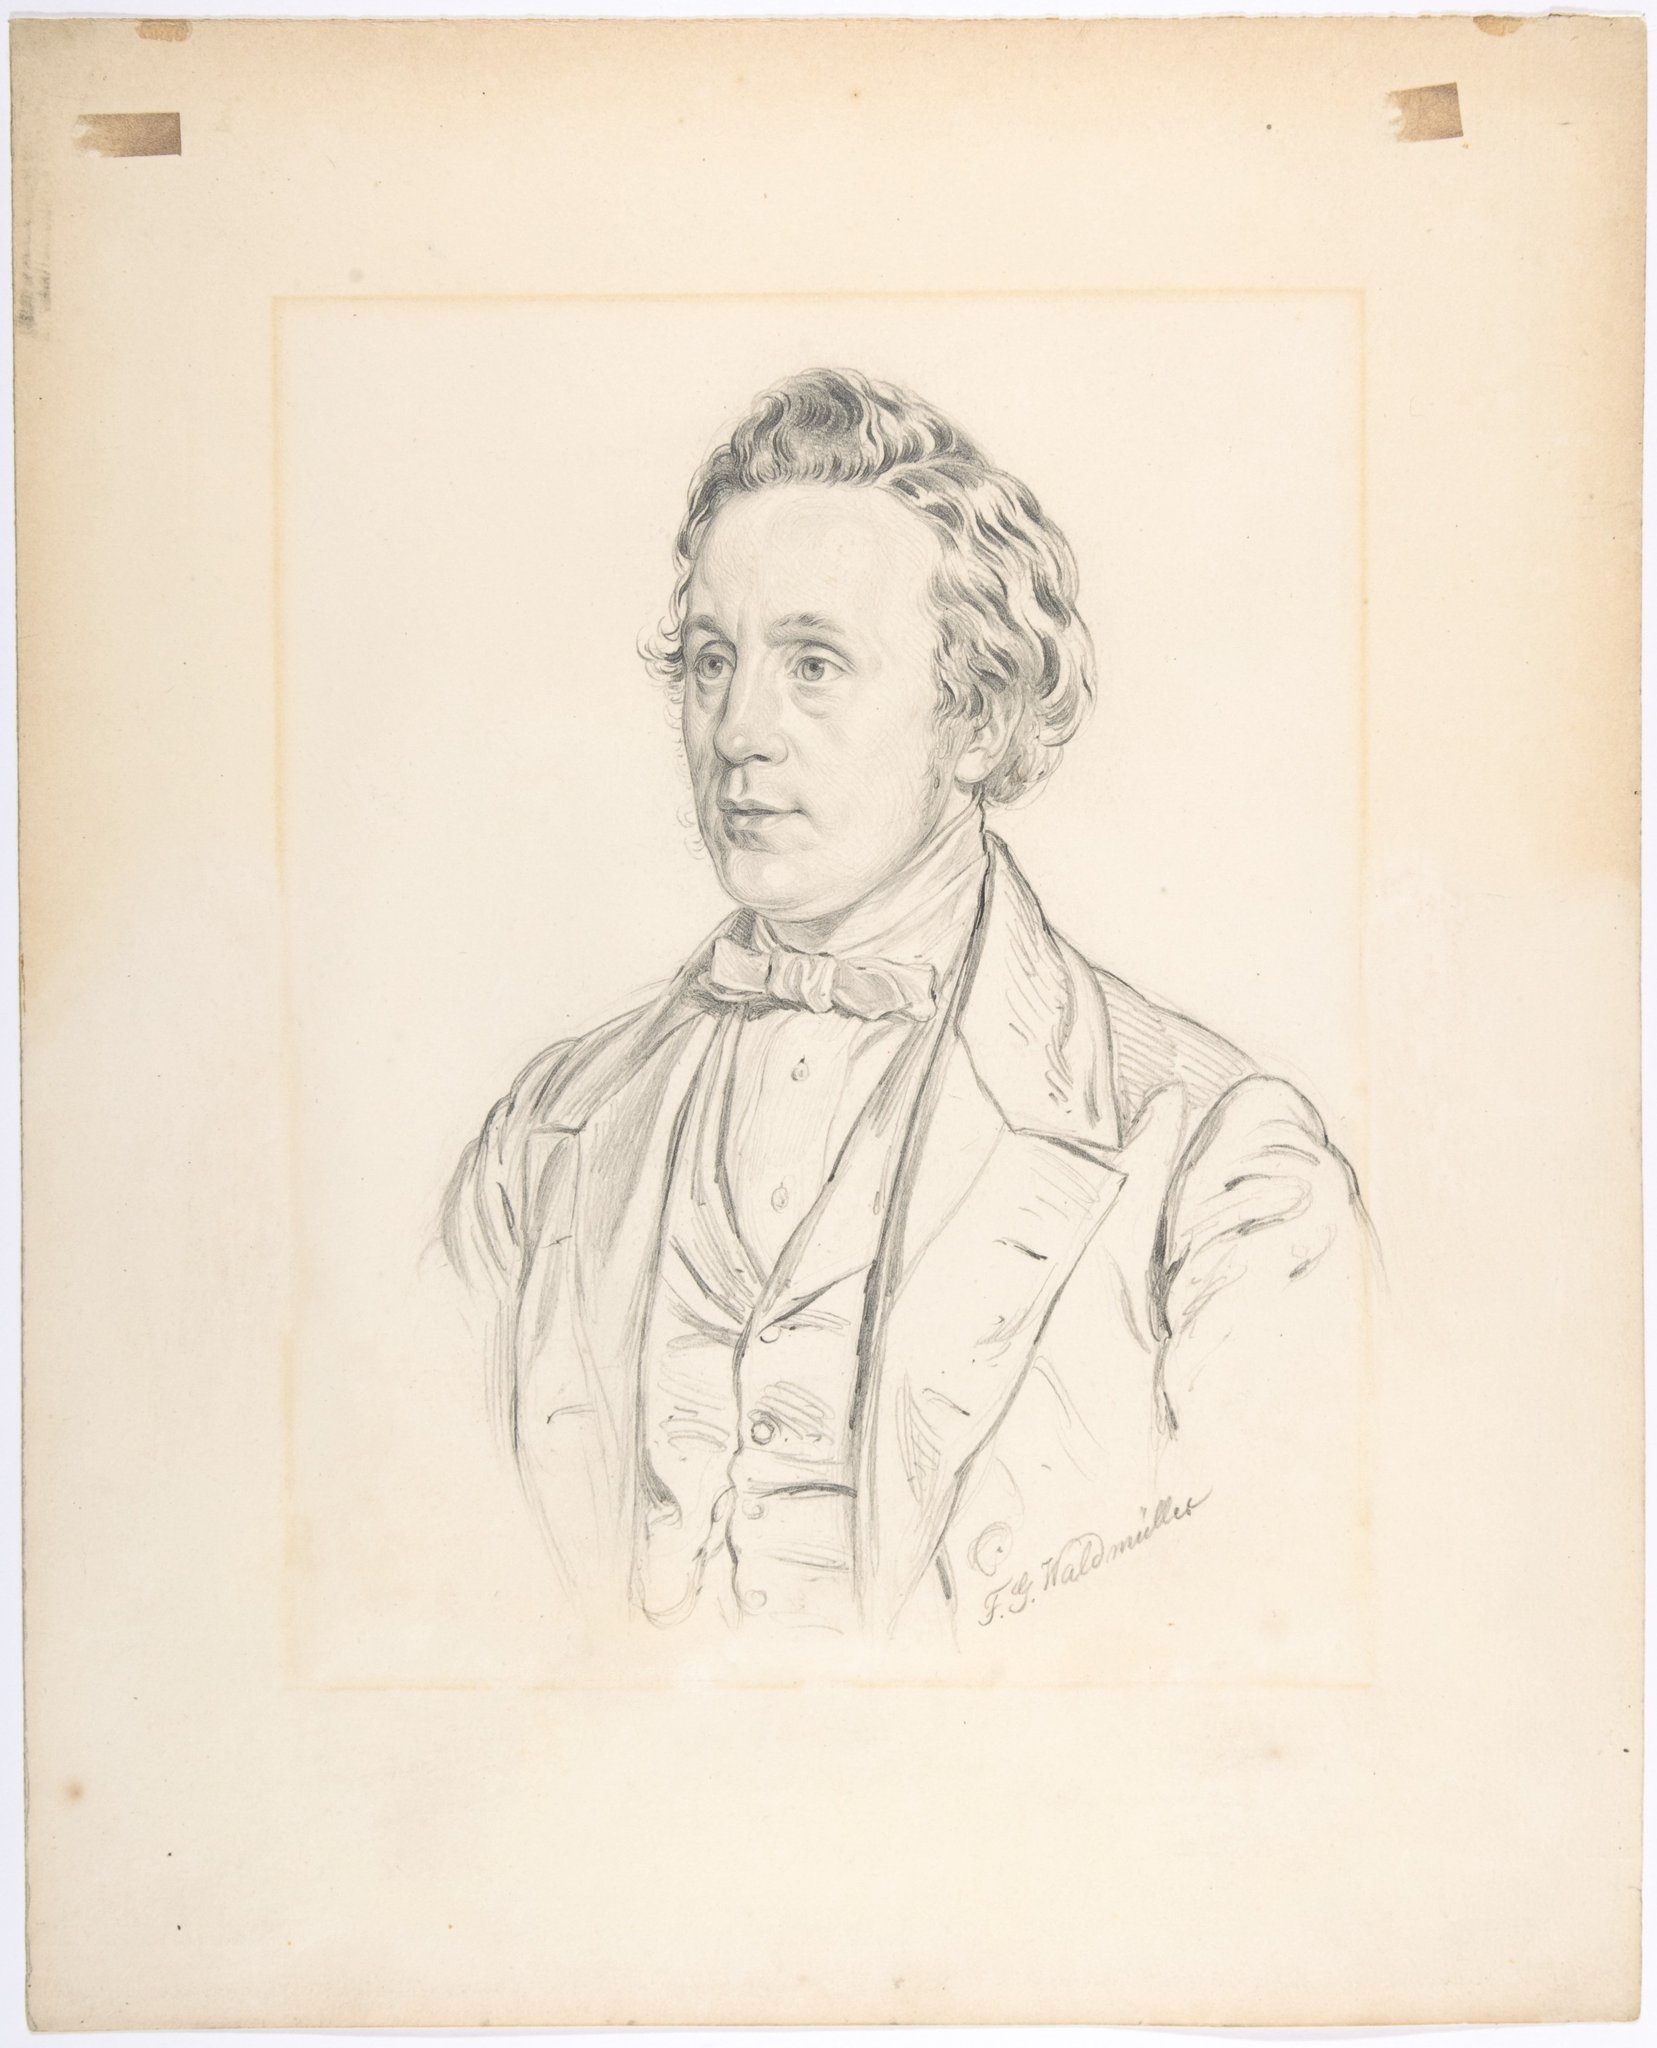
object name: drawing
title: Portrait of Franz Jauner (Vienna 1832-1900 Vienna), Theater Director and Actor in Vienna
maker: ferdinand georg waldmüller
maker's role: artist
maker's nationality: austrian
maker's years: 1793-1865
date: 1800-1865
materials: graphite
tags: men,portraits,actors